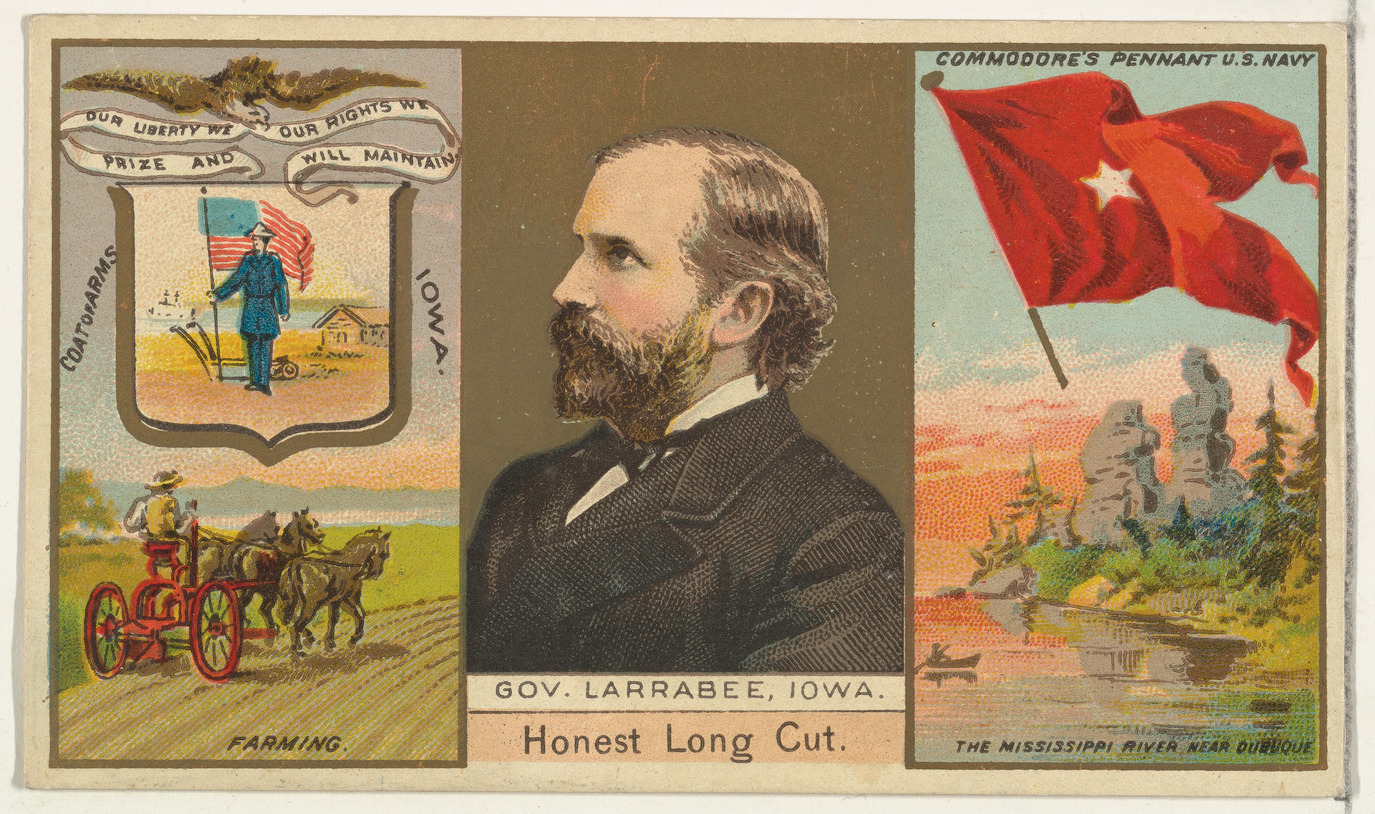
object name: print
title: Governor Larrabee, Iowa, from "Governors, Arms, Etc." series (N133-1), issued by Duke Sons & Co.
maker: w. duke, sons & co.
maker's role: publisher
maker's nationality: american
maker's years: 1870-1920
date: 1888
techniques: color lithograph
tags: men,profiles,coat of arms,flags